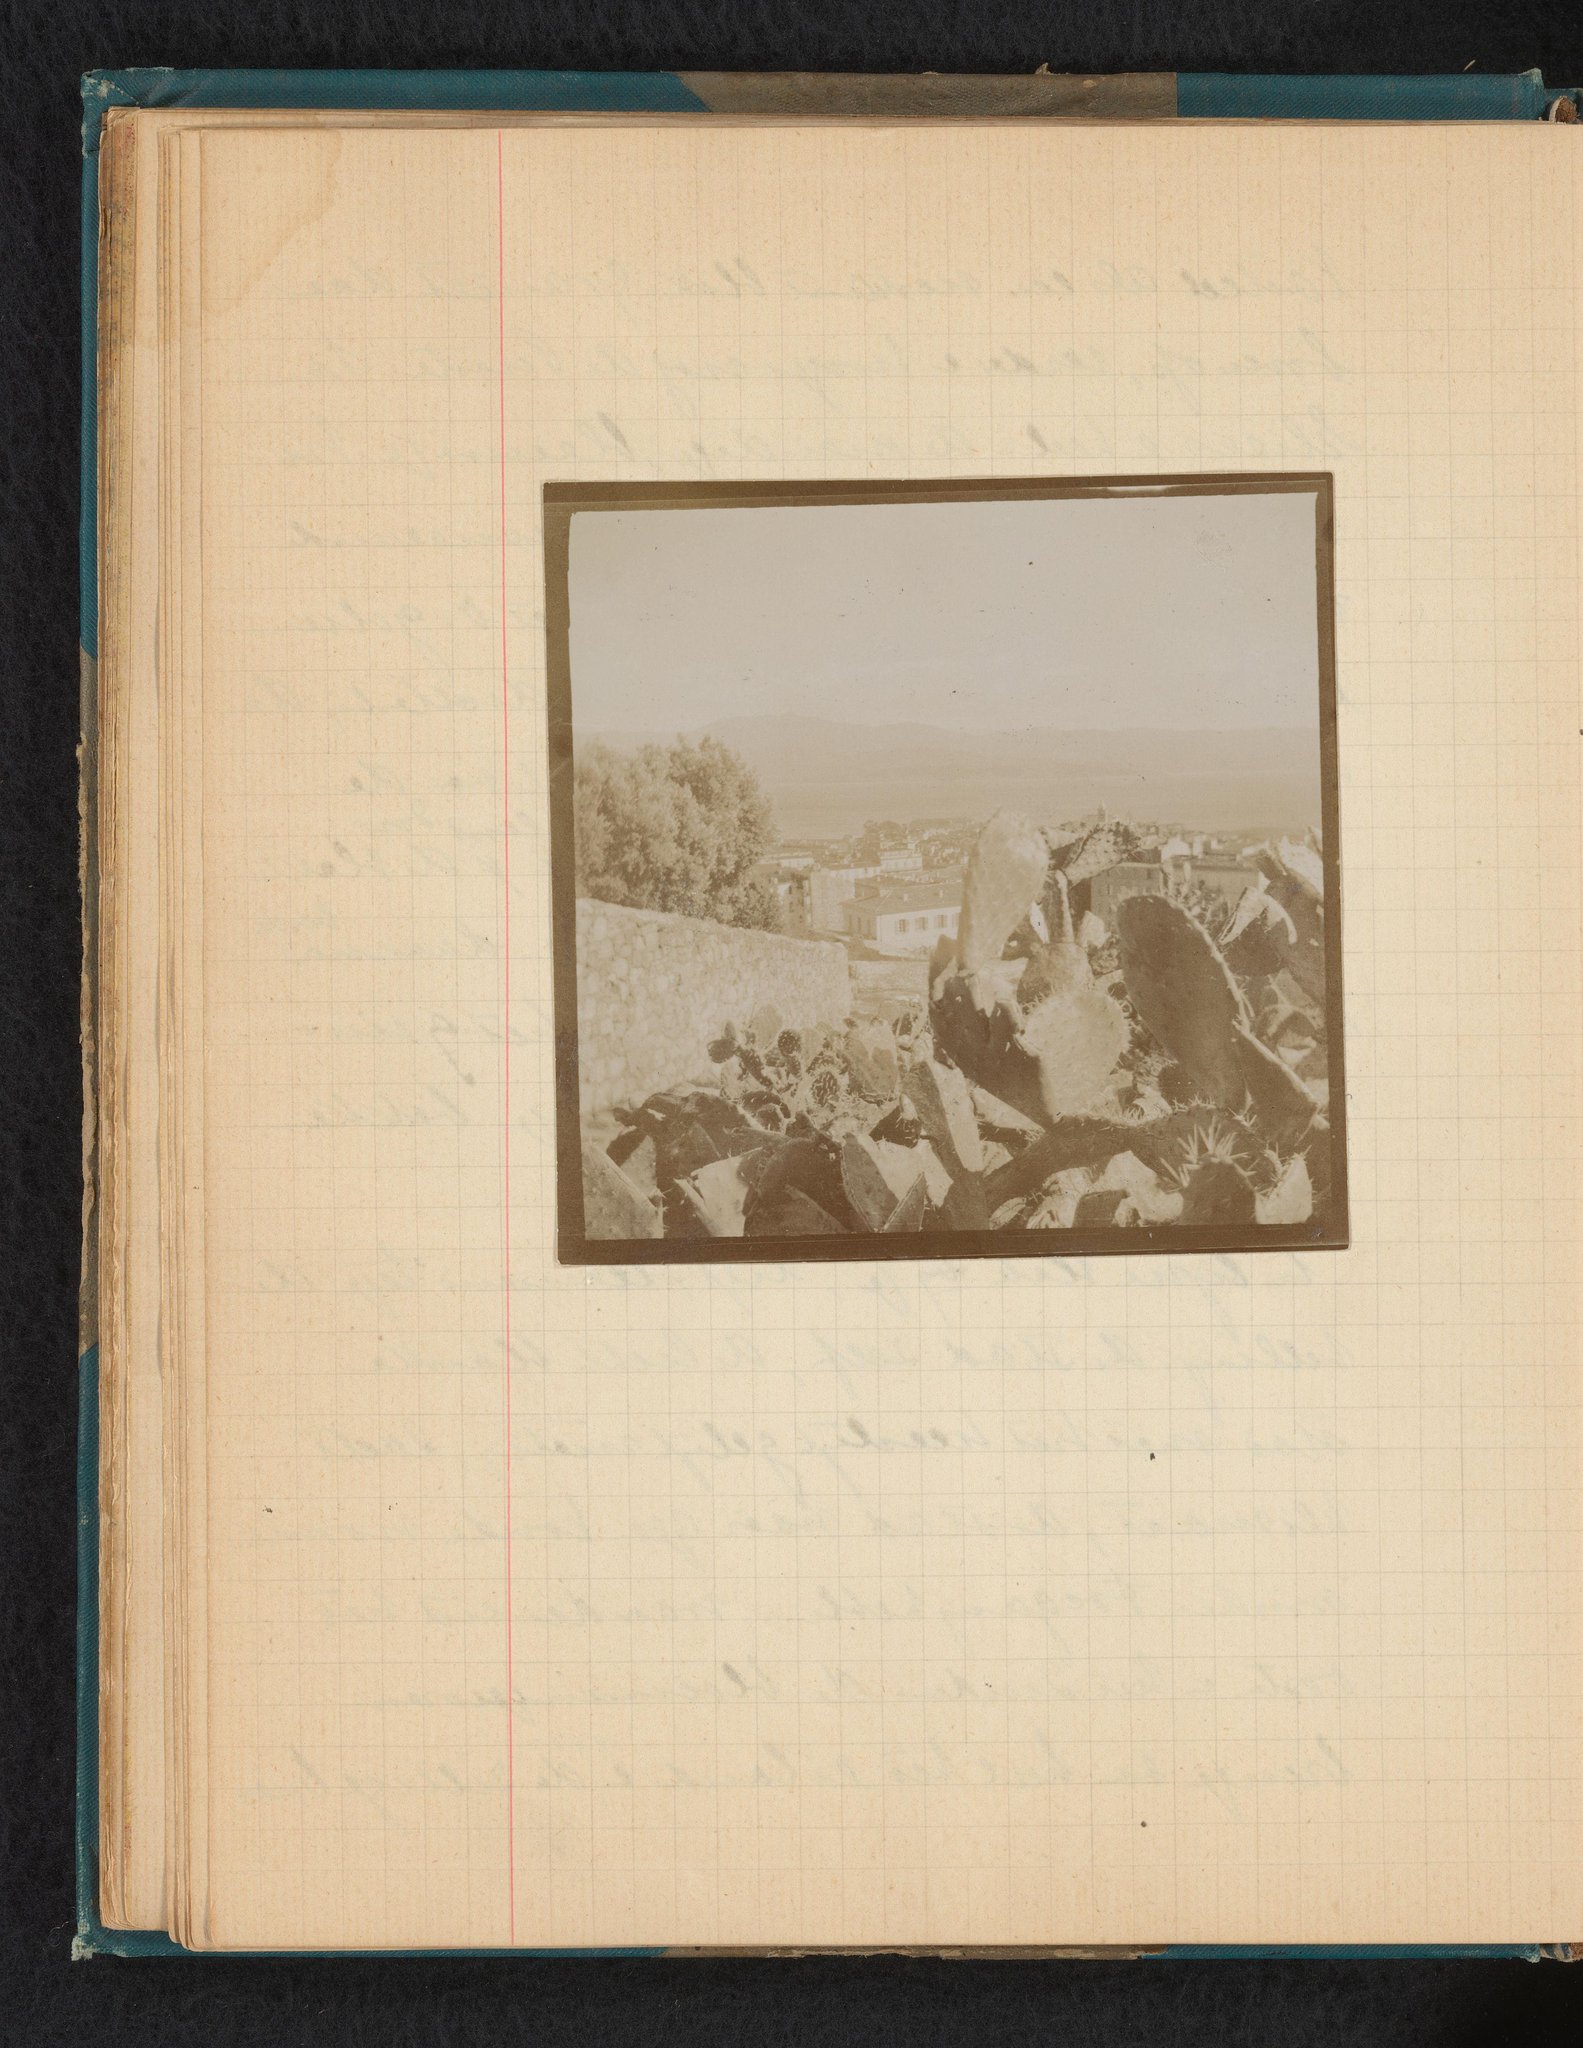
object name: photograph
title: Gezicht op de baai van Ajaccio met cactussen ervoor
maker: théodore van lelyveld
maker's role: painter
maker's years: 1867-1954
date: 1902-1904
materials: paper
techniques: gelatin silver print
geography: ajaccio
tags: gulf, bay, city-view in general; 'veduta', plants and herbs: cactus